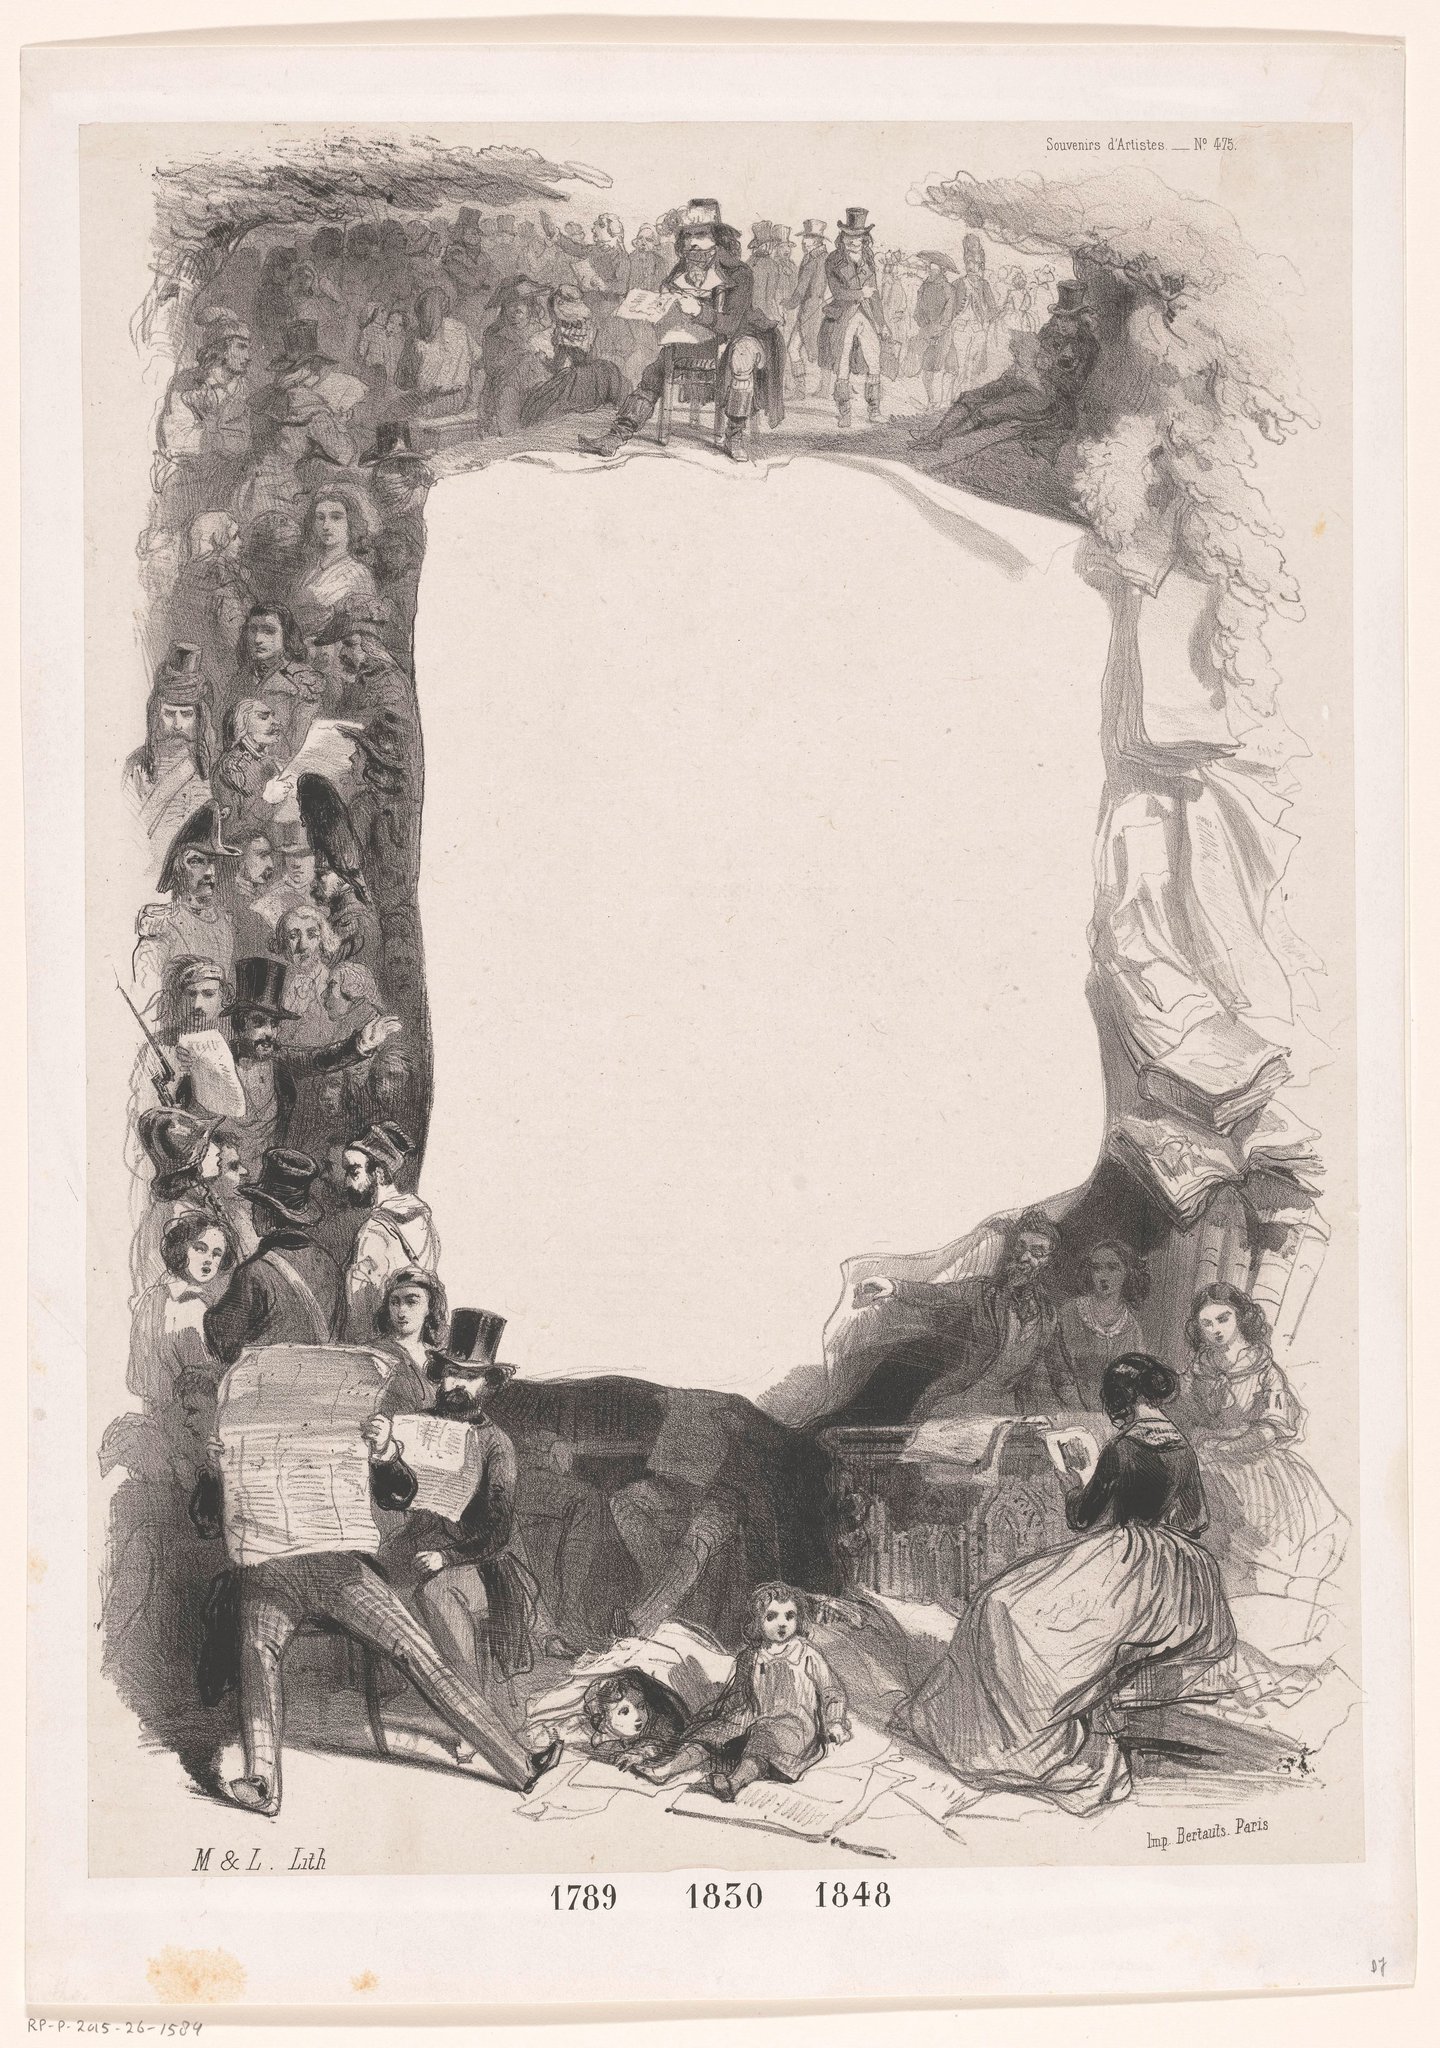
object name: print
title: Souvenirs d'Artistes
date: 1848-1880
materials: paper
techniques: lithograph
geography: paris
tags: reading, private soldier, book, newspaper, news-sheet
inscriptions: collector's mark: Lugt 2228, collector's mark: Lugt 4779, collector's mark: Lugt 4780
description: Aan de bovenzijde van de omlijsting zit een man achterstevoren op een stoel met een krant of tijdschrift in zijn handen. Onderin twee kranten lezende mannen en vrouwen. Rechts bestaat de omlijsting uit stapels papier en boeken.